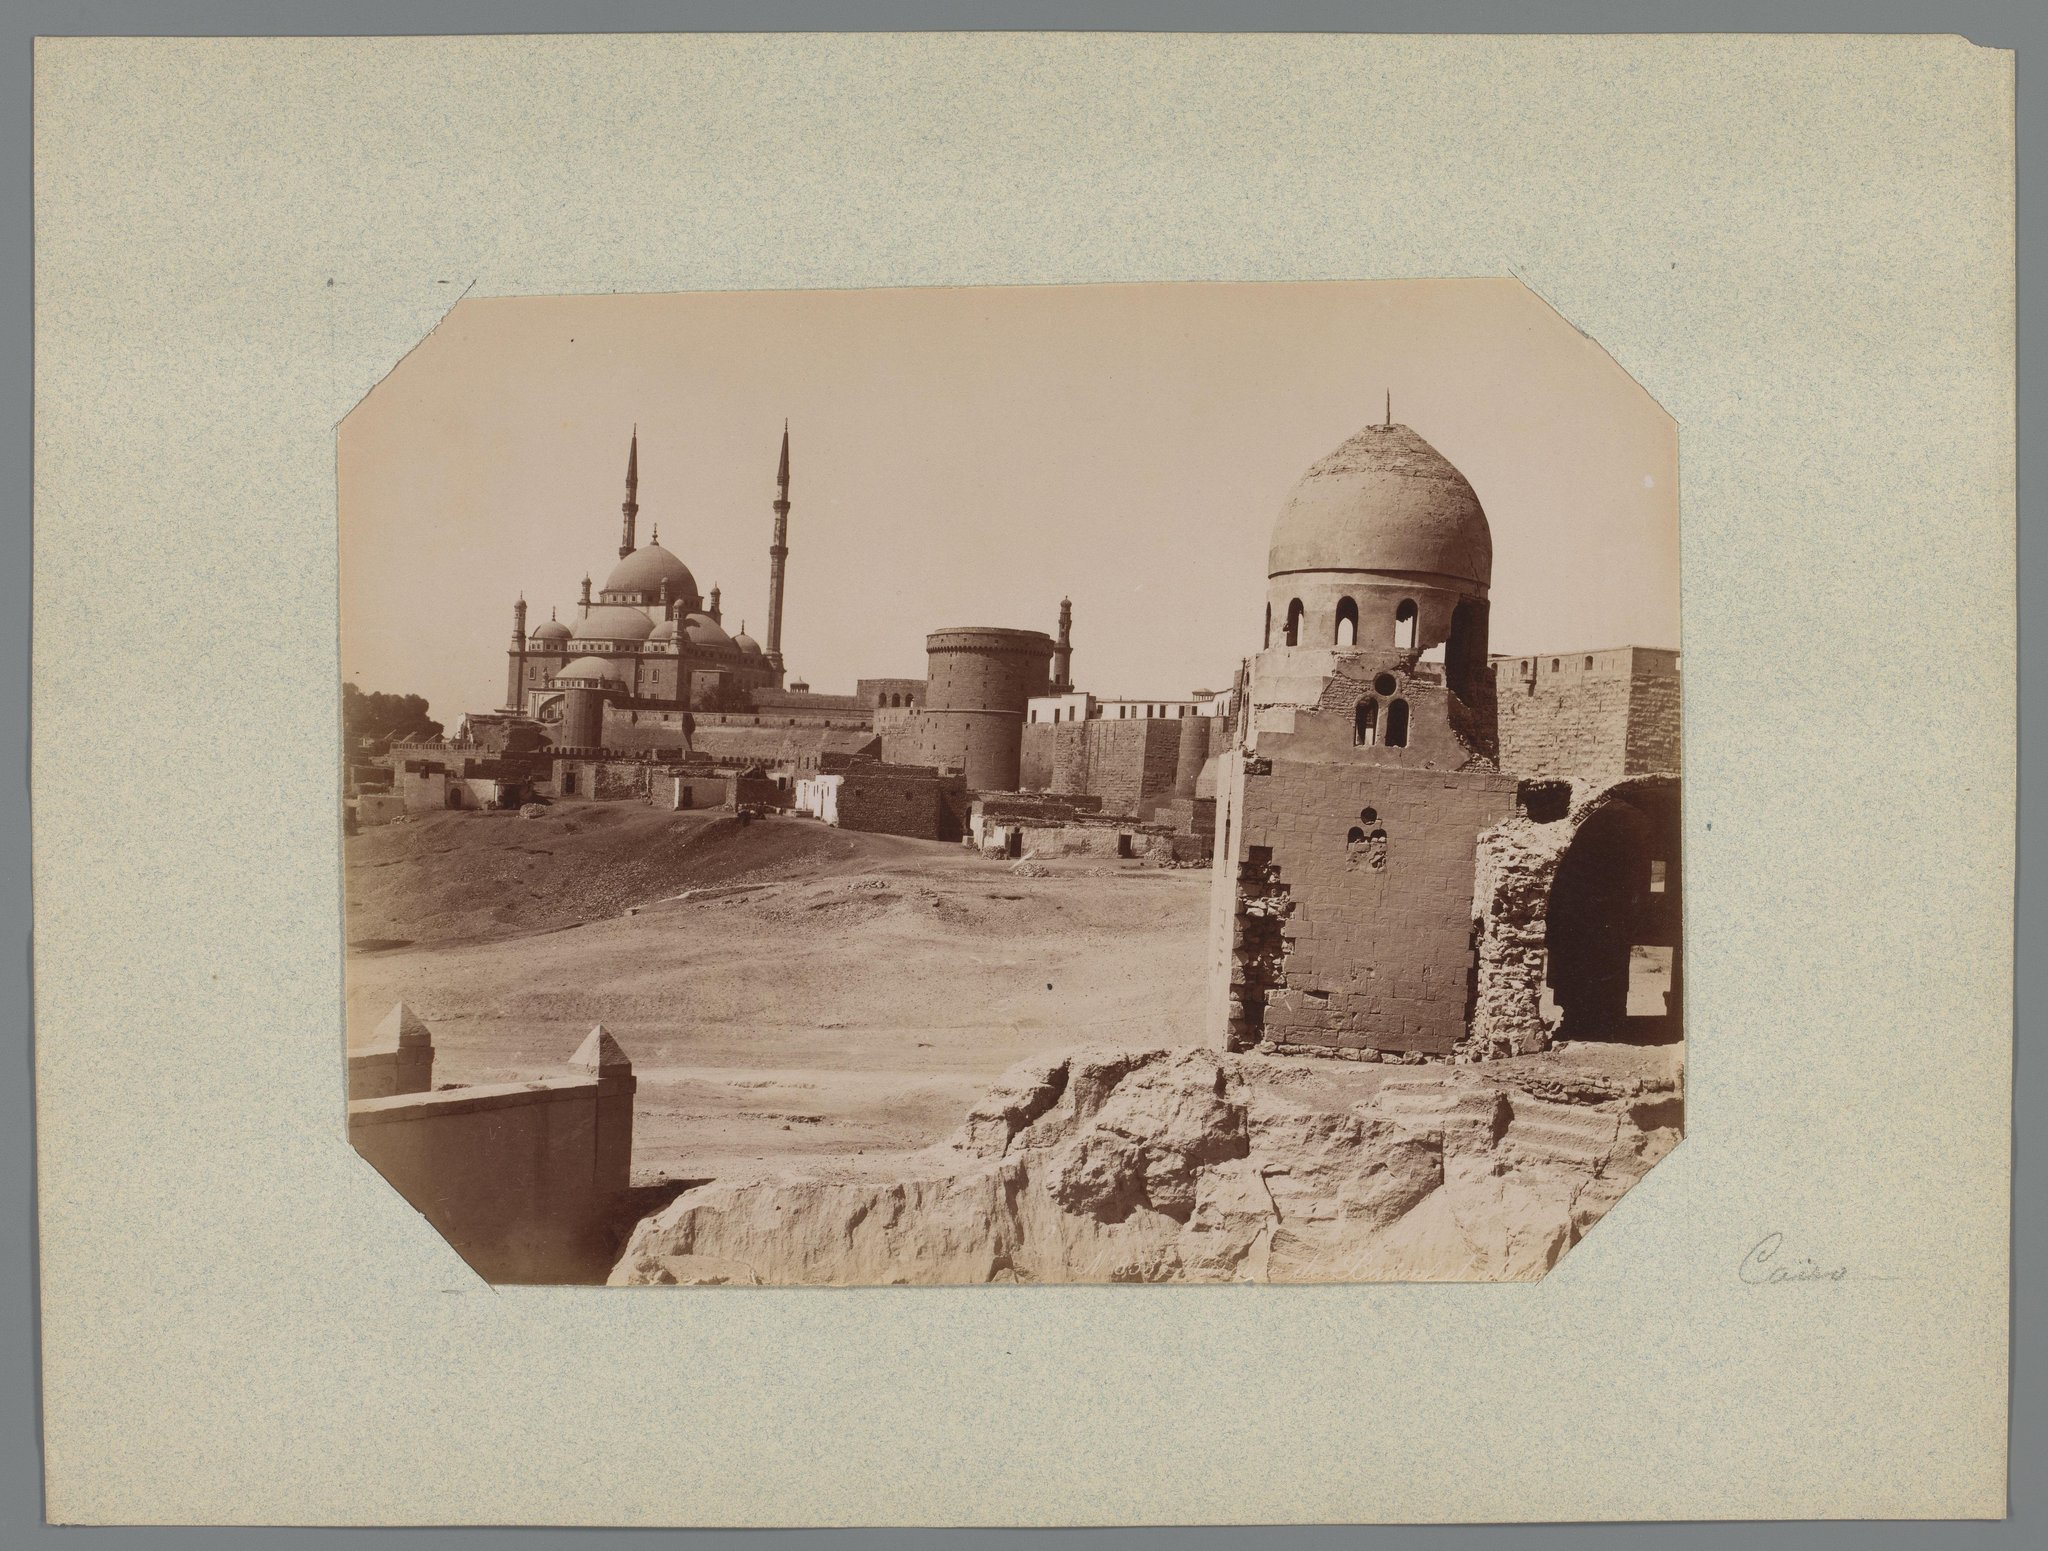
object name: photograph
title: Mosquée de Bahoul et [...]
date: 1870-1910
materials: cardboard, paper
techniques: albumen print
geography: cairo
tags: temple, shrine ~ islam, mohammedanism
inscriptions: number: ‘No 833’